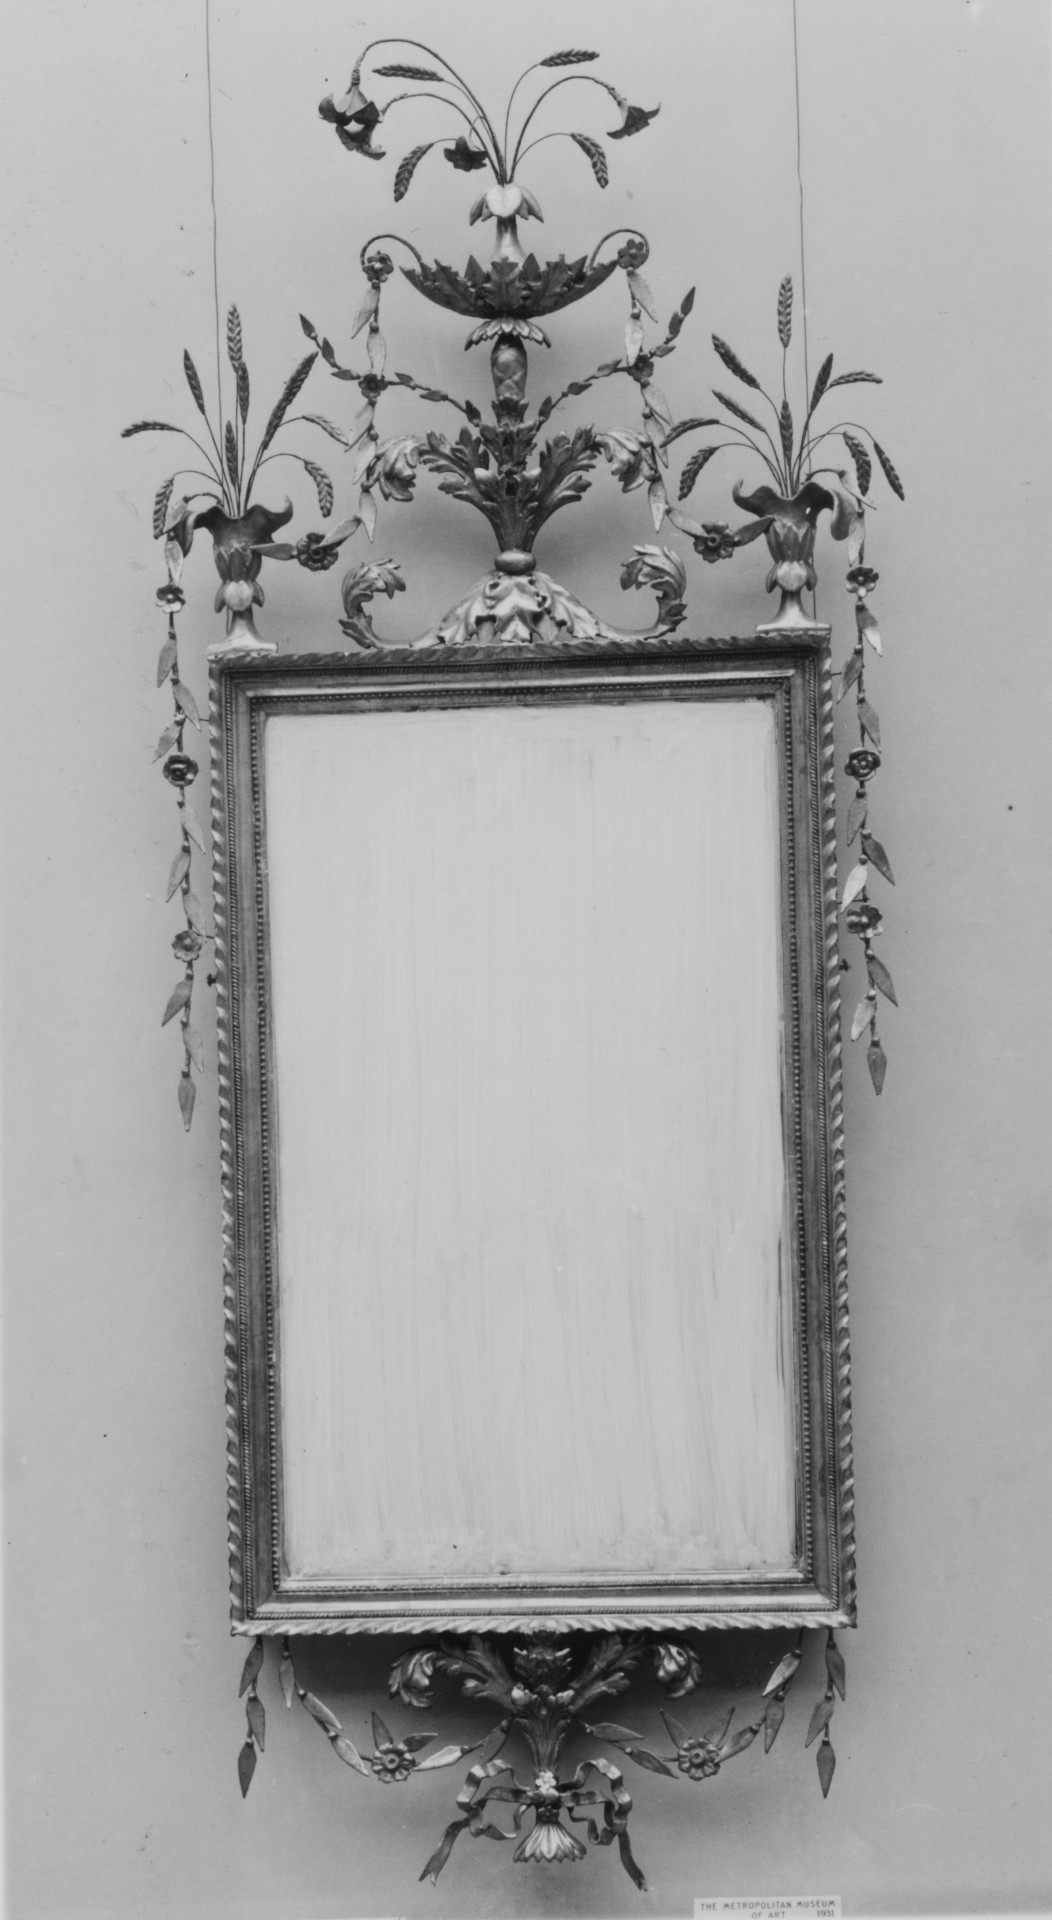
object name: pier glass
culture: american or british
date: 1790-1805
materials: gesso, glass, wood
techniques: gilding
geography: england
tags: plants